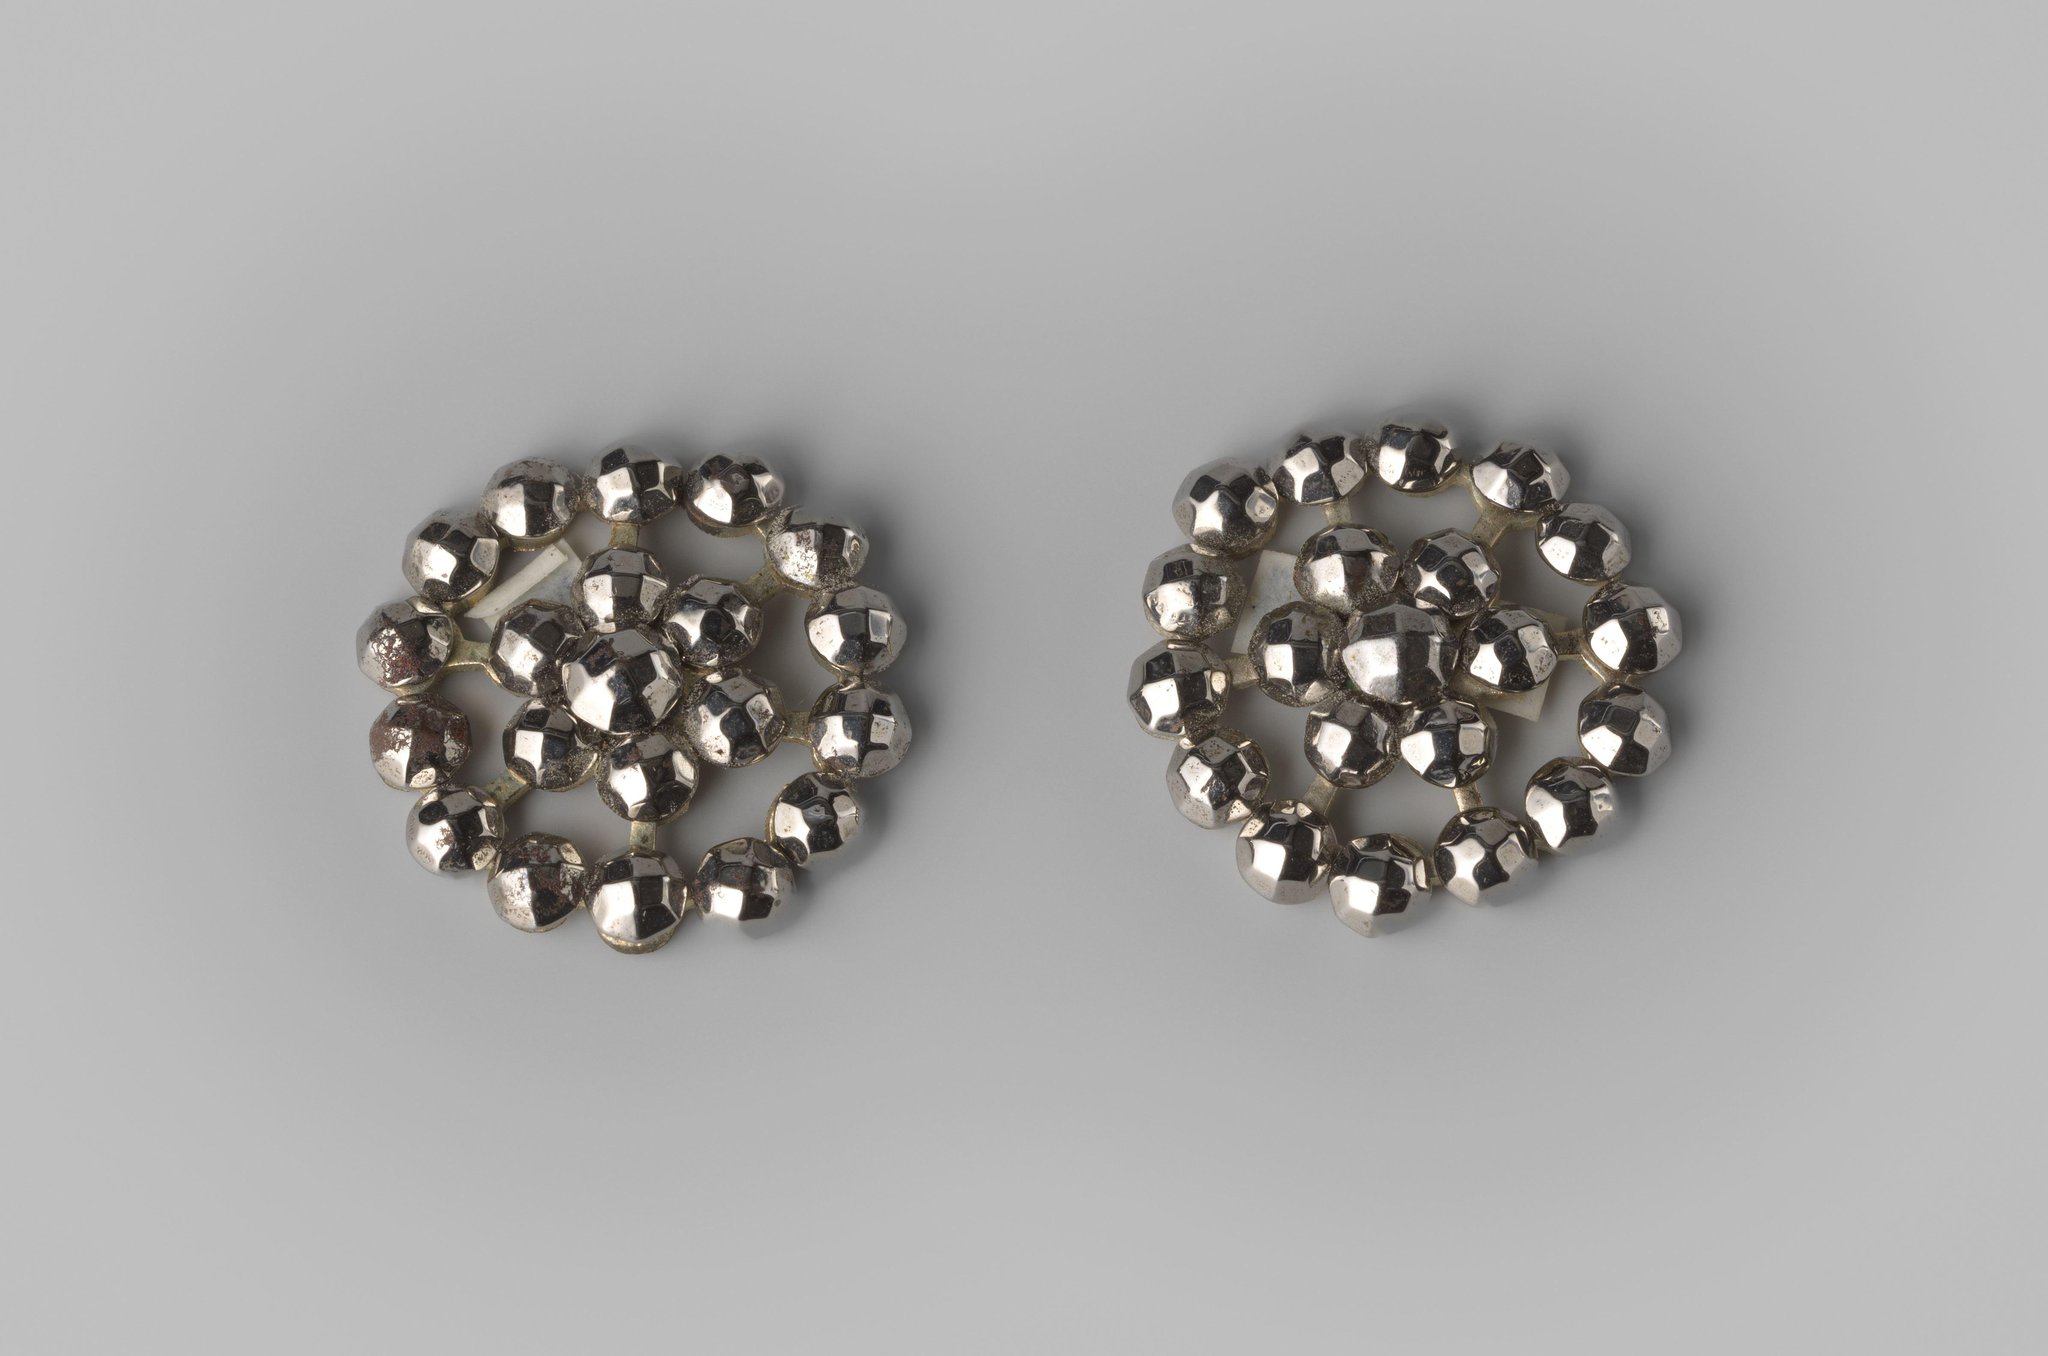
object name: button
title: Twee knopen van in diamantvorm geslepen staal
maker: Anonymous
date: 1785-1800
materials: steel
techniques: forging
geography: france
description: Twee sierknoopjes van geslepen staal. Roosje van zeven diamantknopjes omsloten door een cirkel.